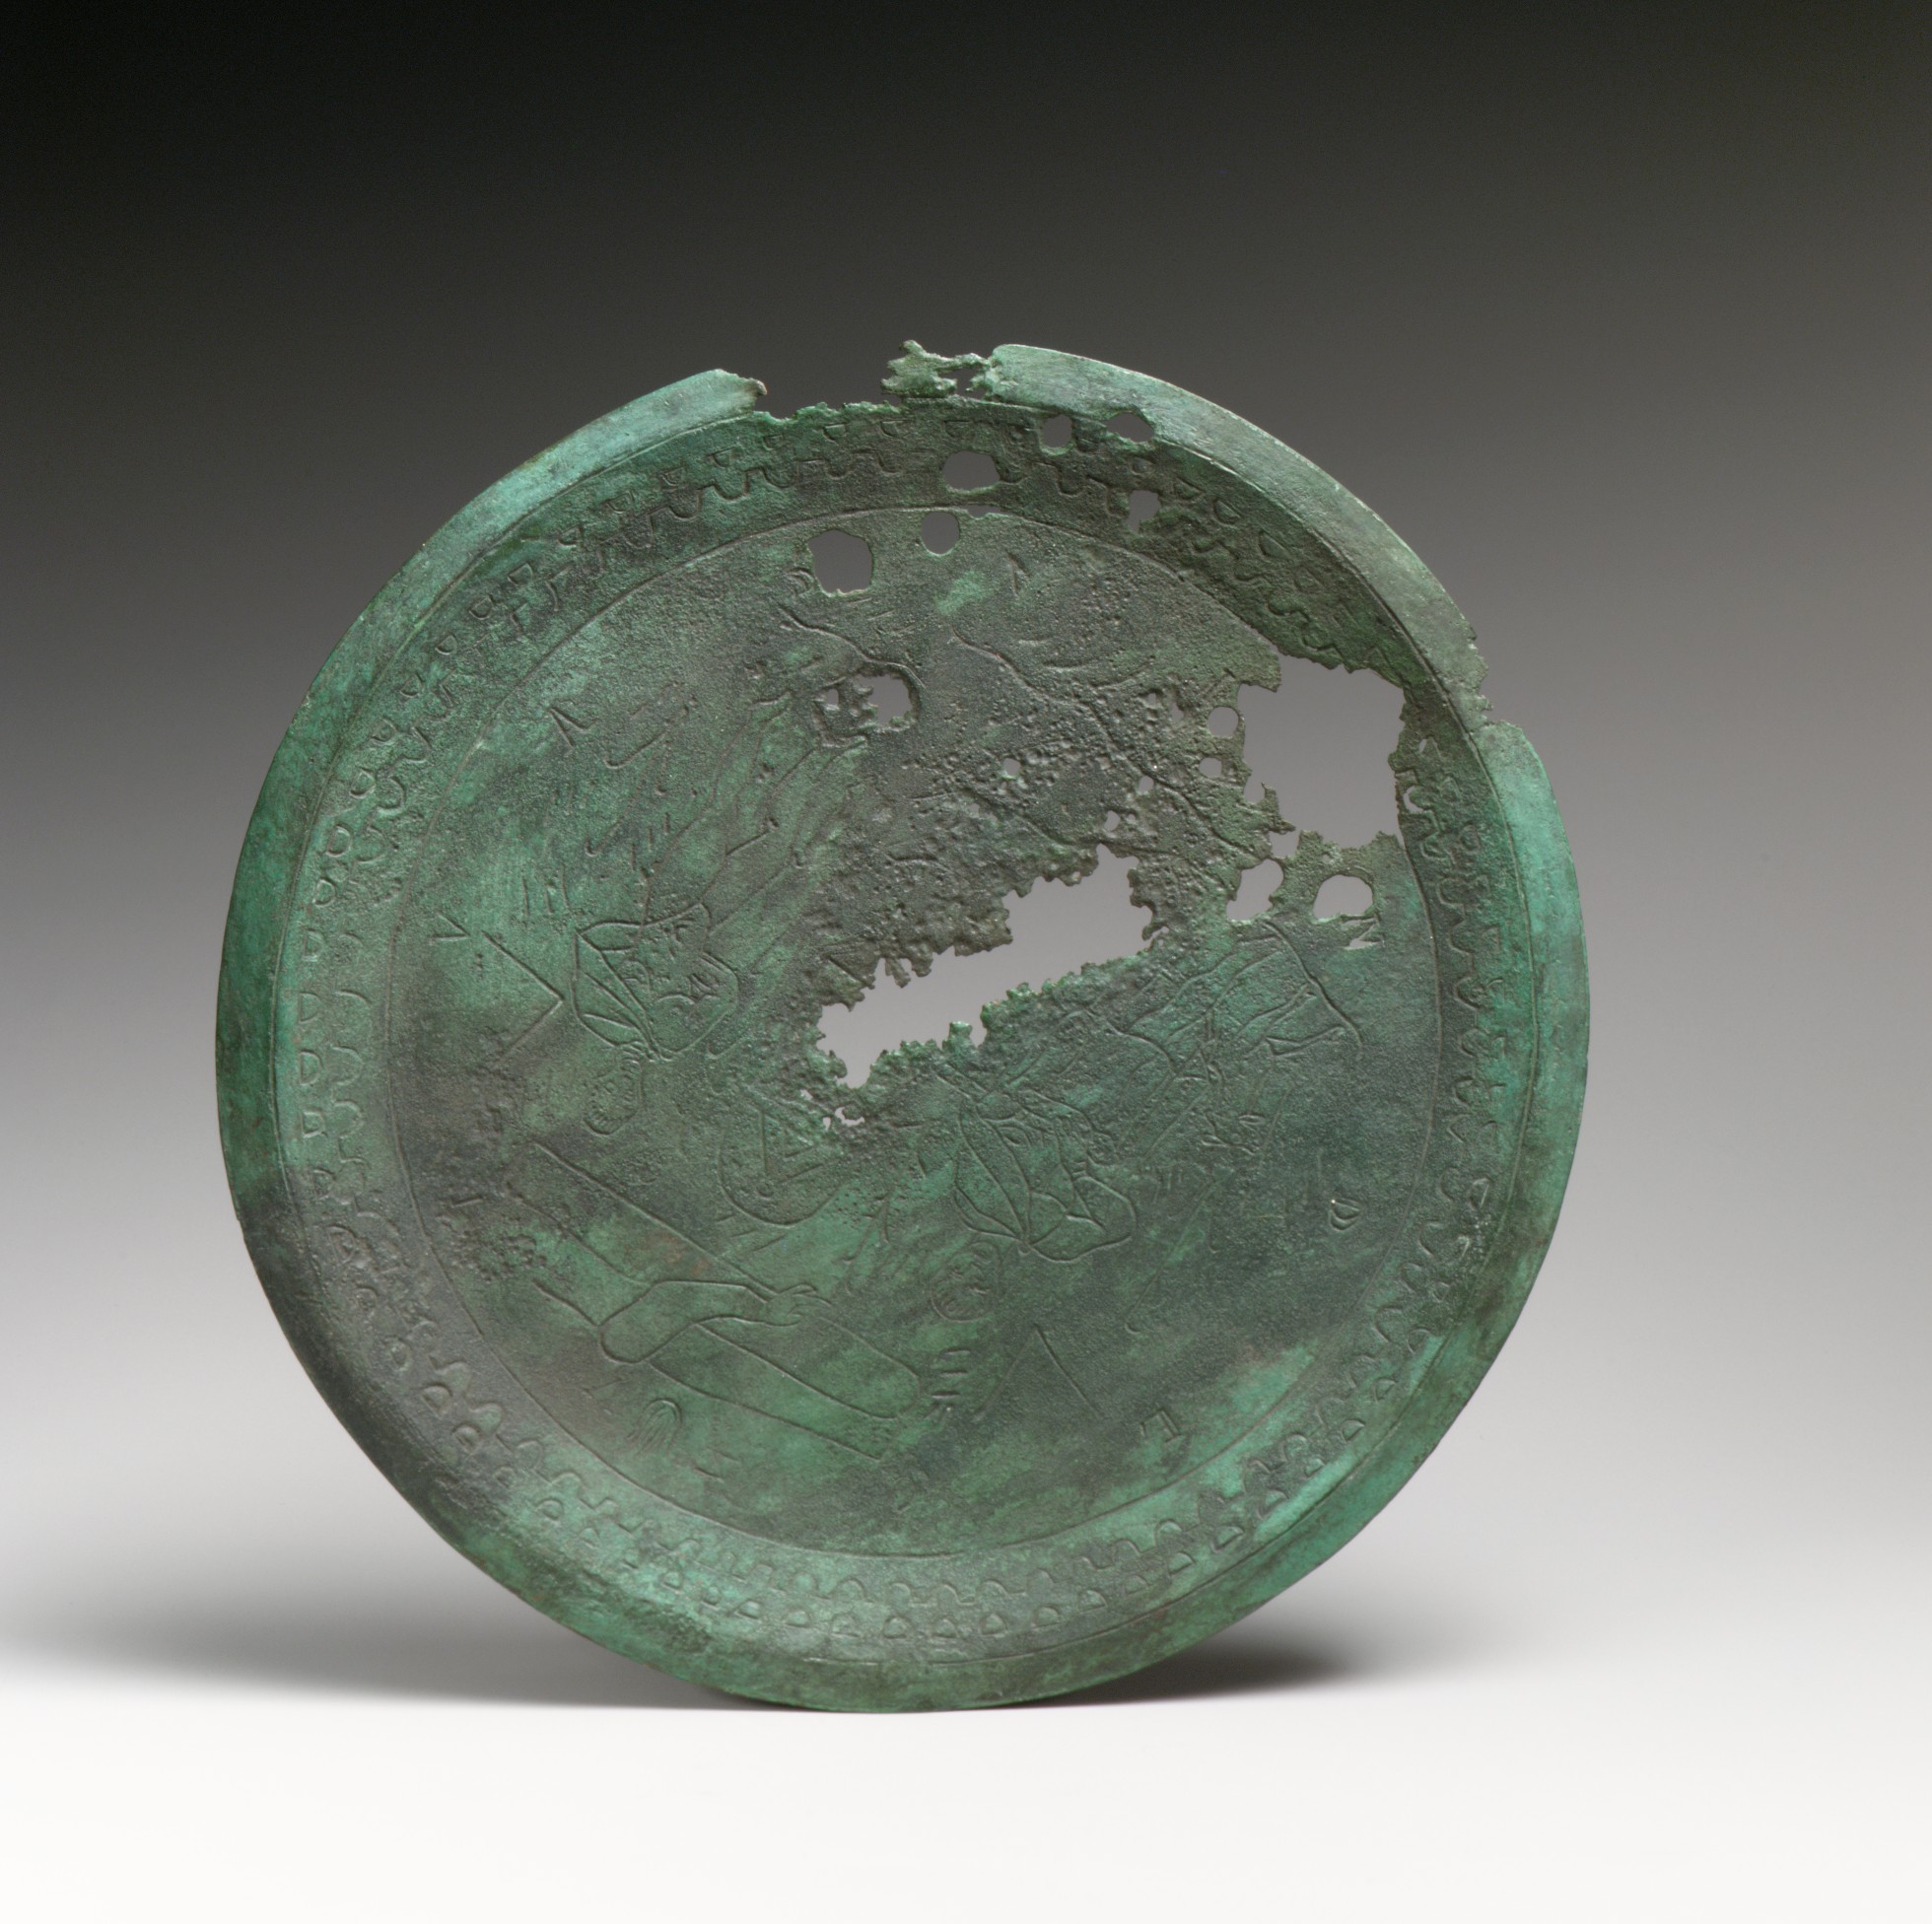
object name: plate with engraving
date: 7000 BCE-330 CE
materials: copper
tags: human figures